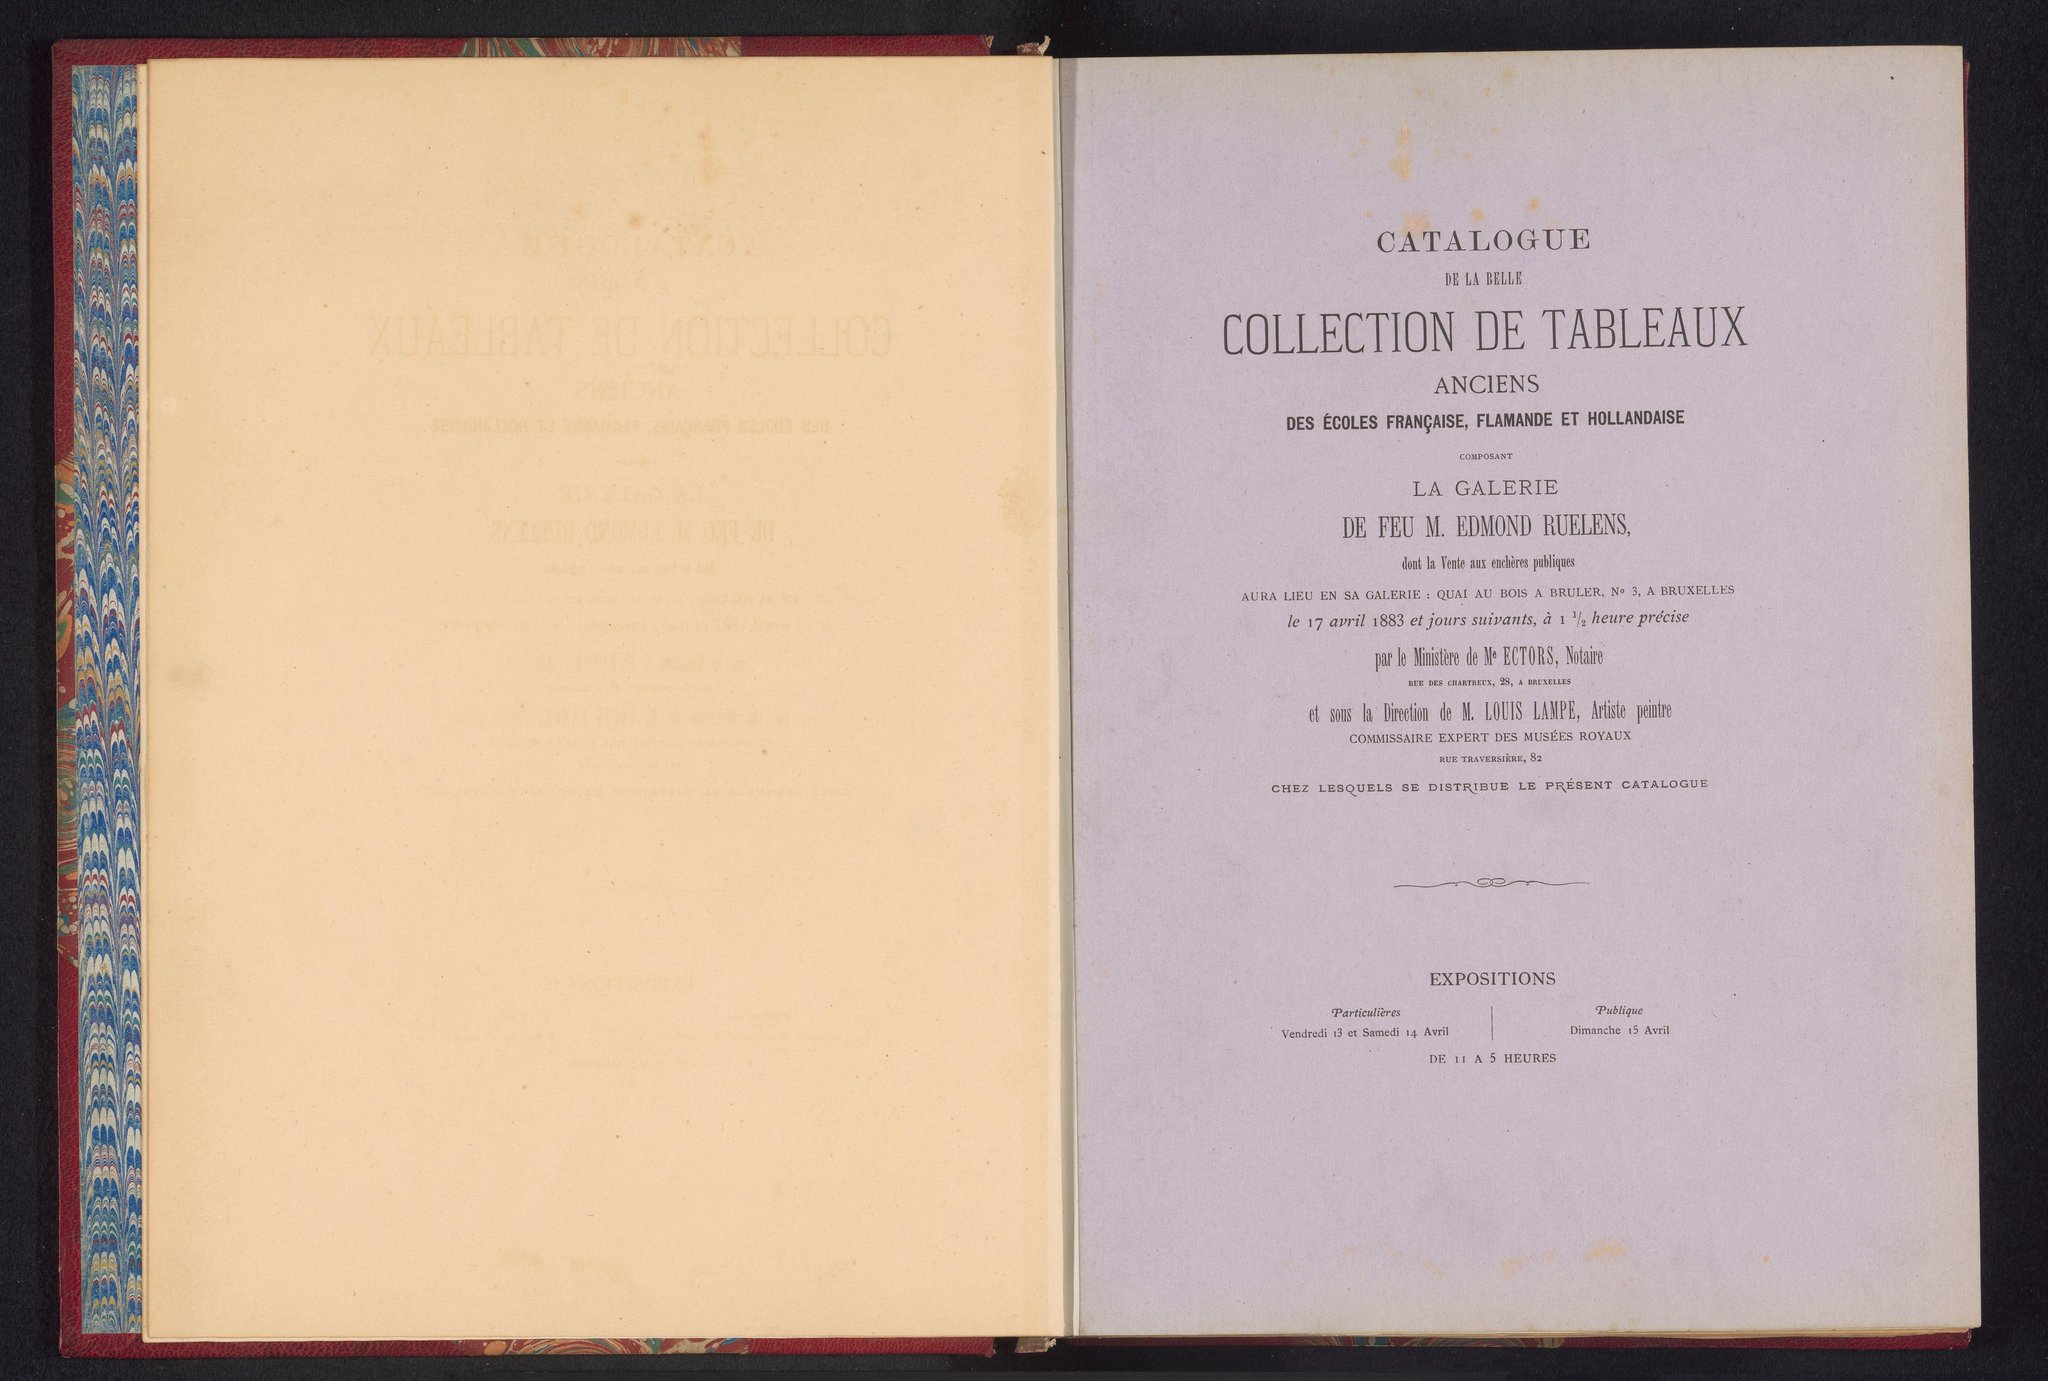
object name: book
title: Catalogue de la belle collection de tableaux anciens des écoles française, flamande et hollandaise composant la galerie de feu M. Edmond Ruelens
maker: Anonymous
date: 1883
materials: cardboard, leather, paper, photographic support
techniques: photograph, marbled paper, printing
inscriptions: collector's mark: ‘Bibliotheek/ Rijksmuseum/ Amsterdam’